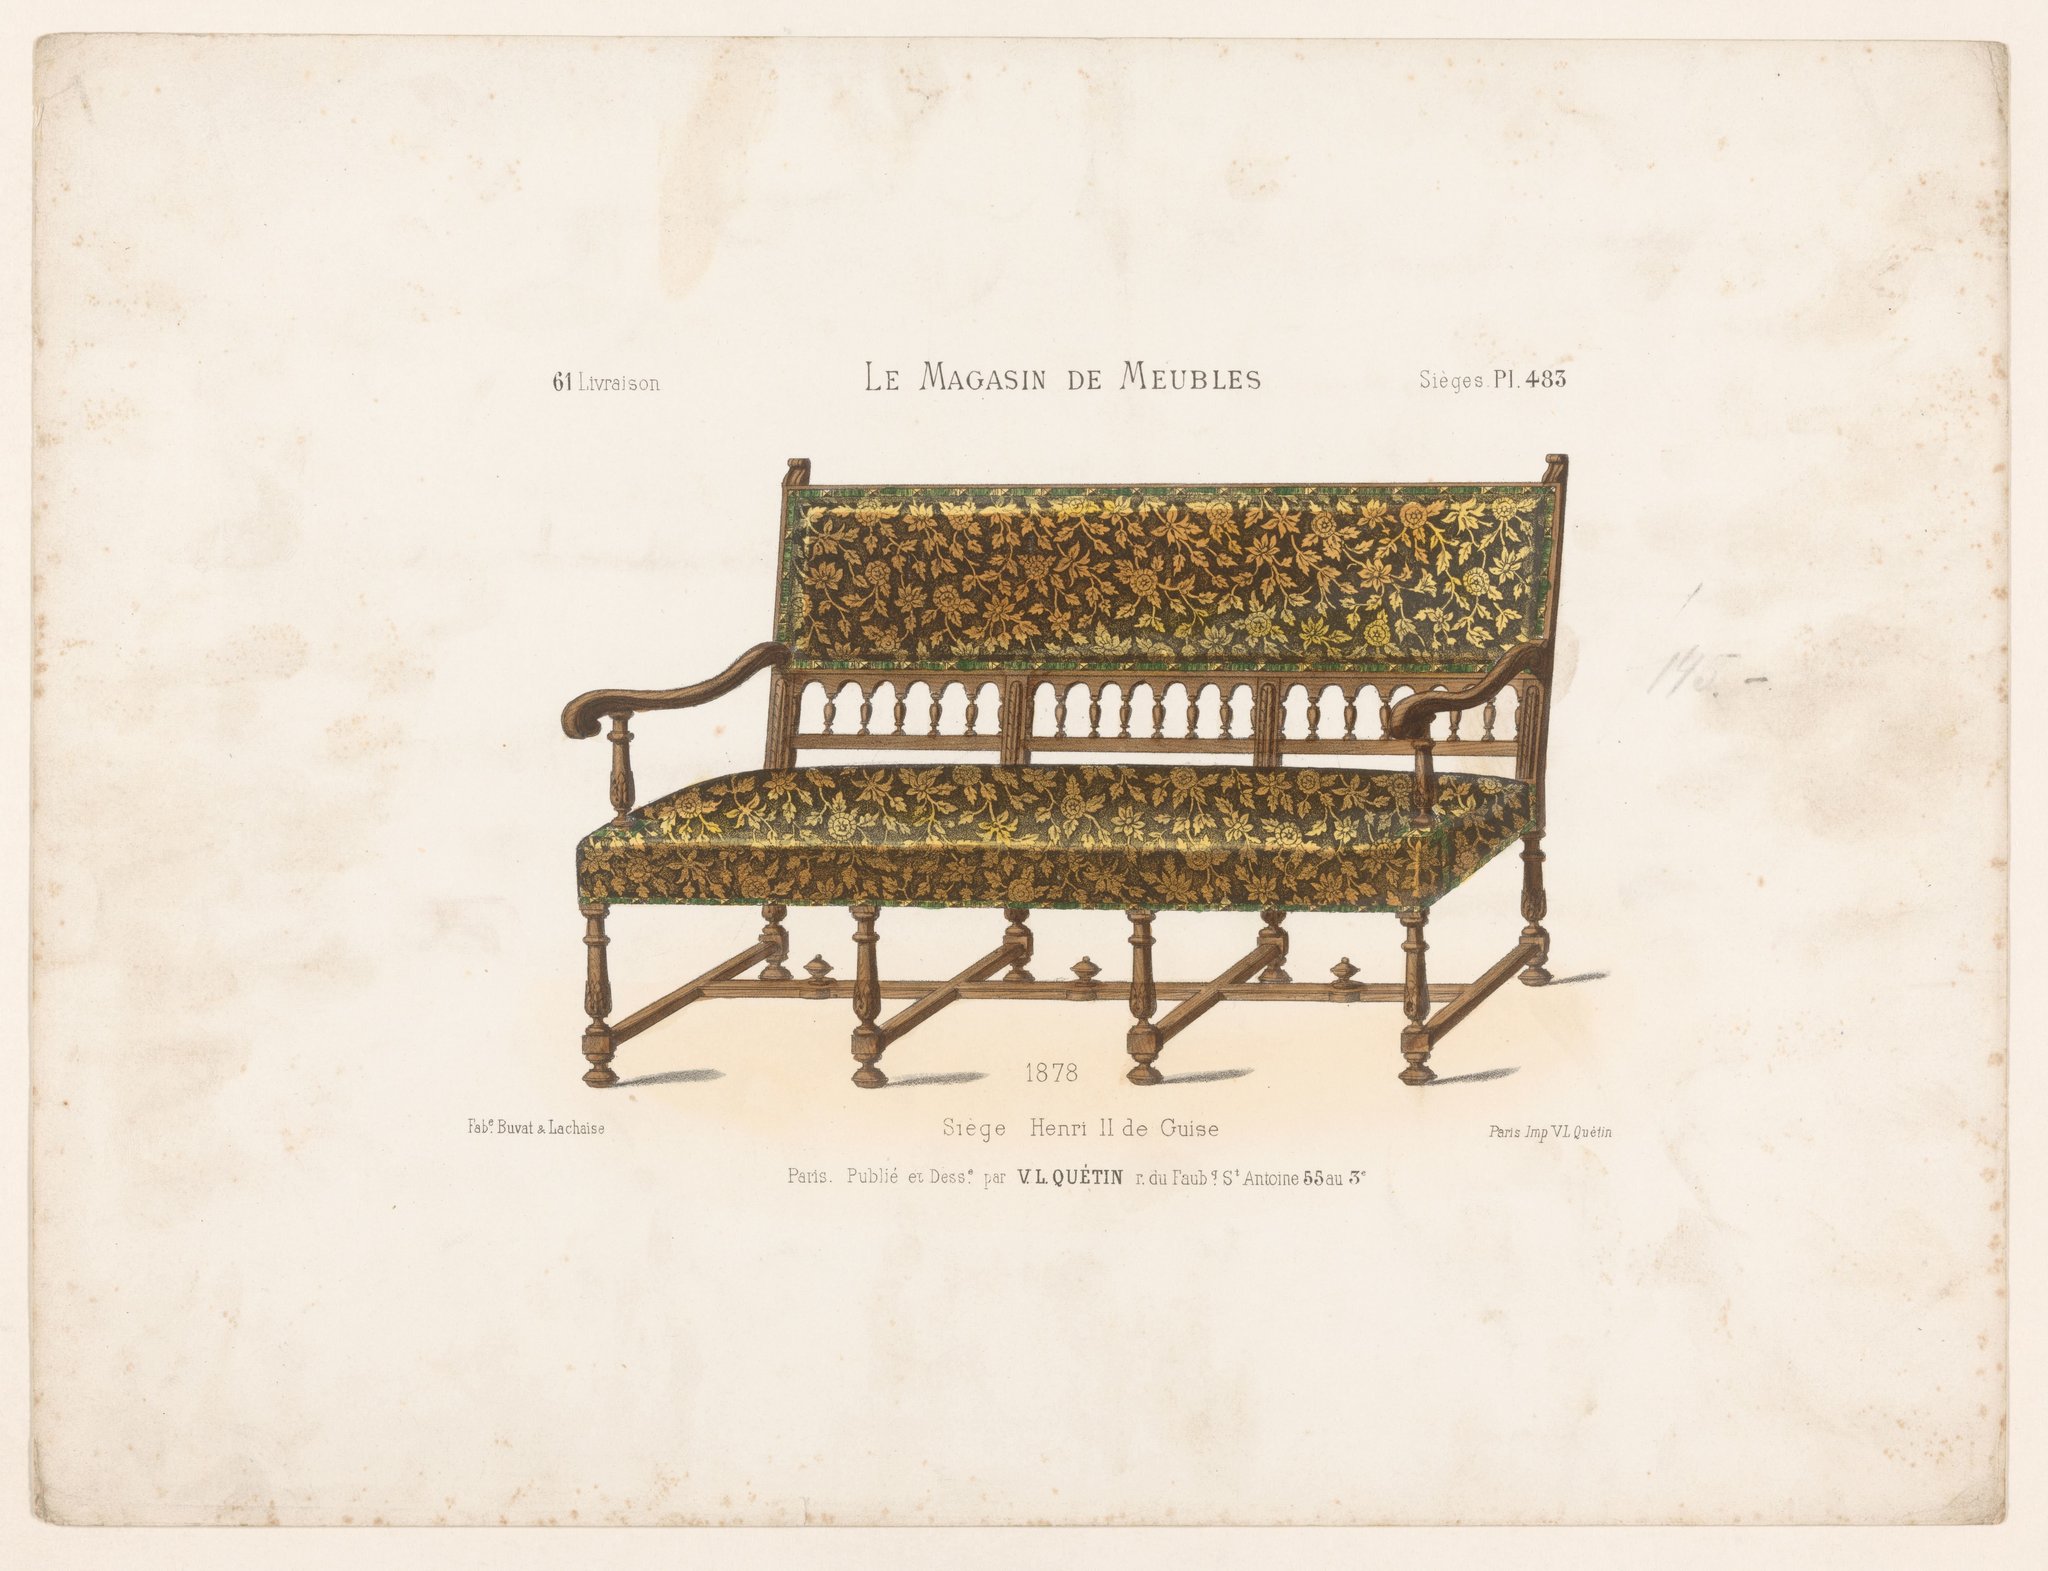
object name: print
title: Bank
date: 1878-1904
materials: paper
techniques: hand coloring, lithograph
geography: paris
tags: seating furniture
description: Een bank in de Hendrik II-stijl. Prent uit 61e Livraison.